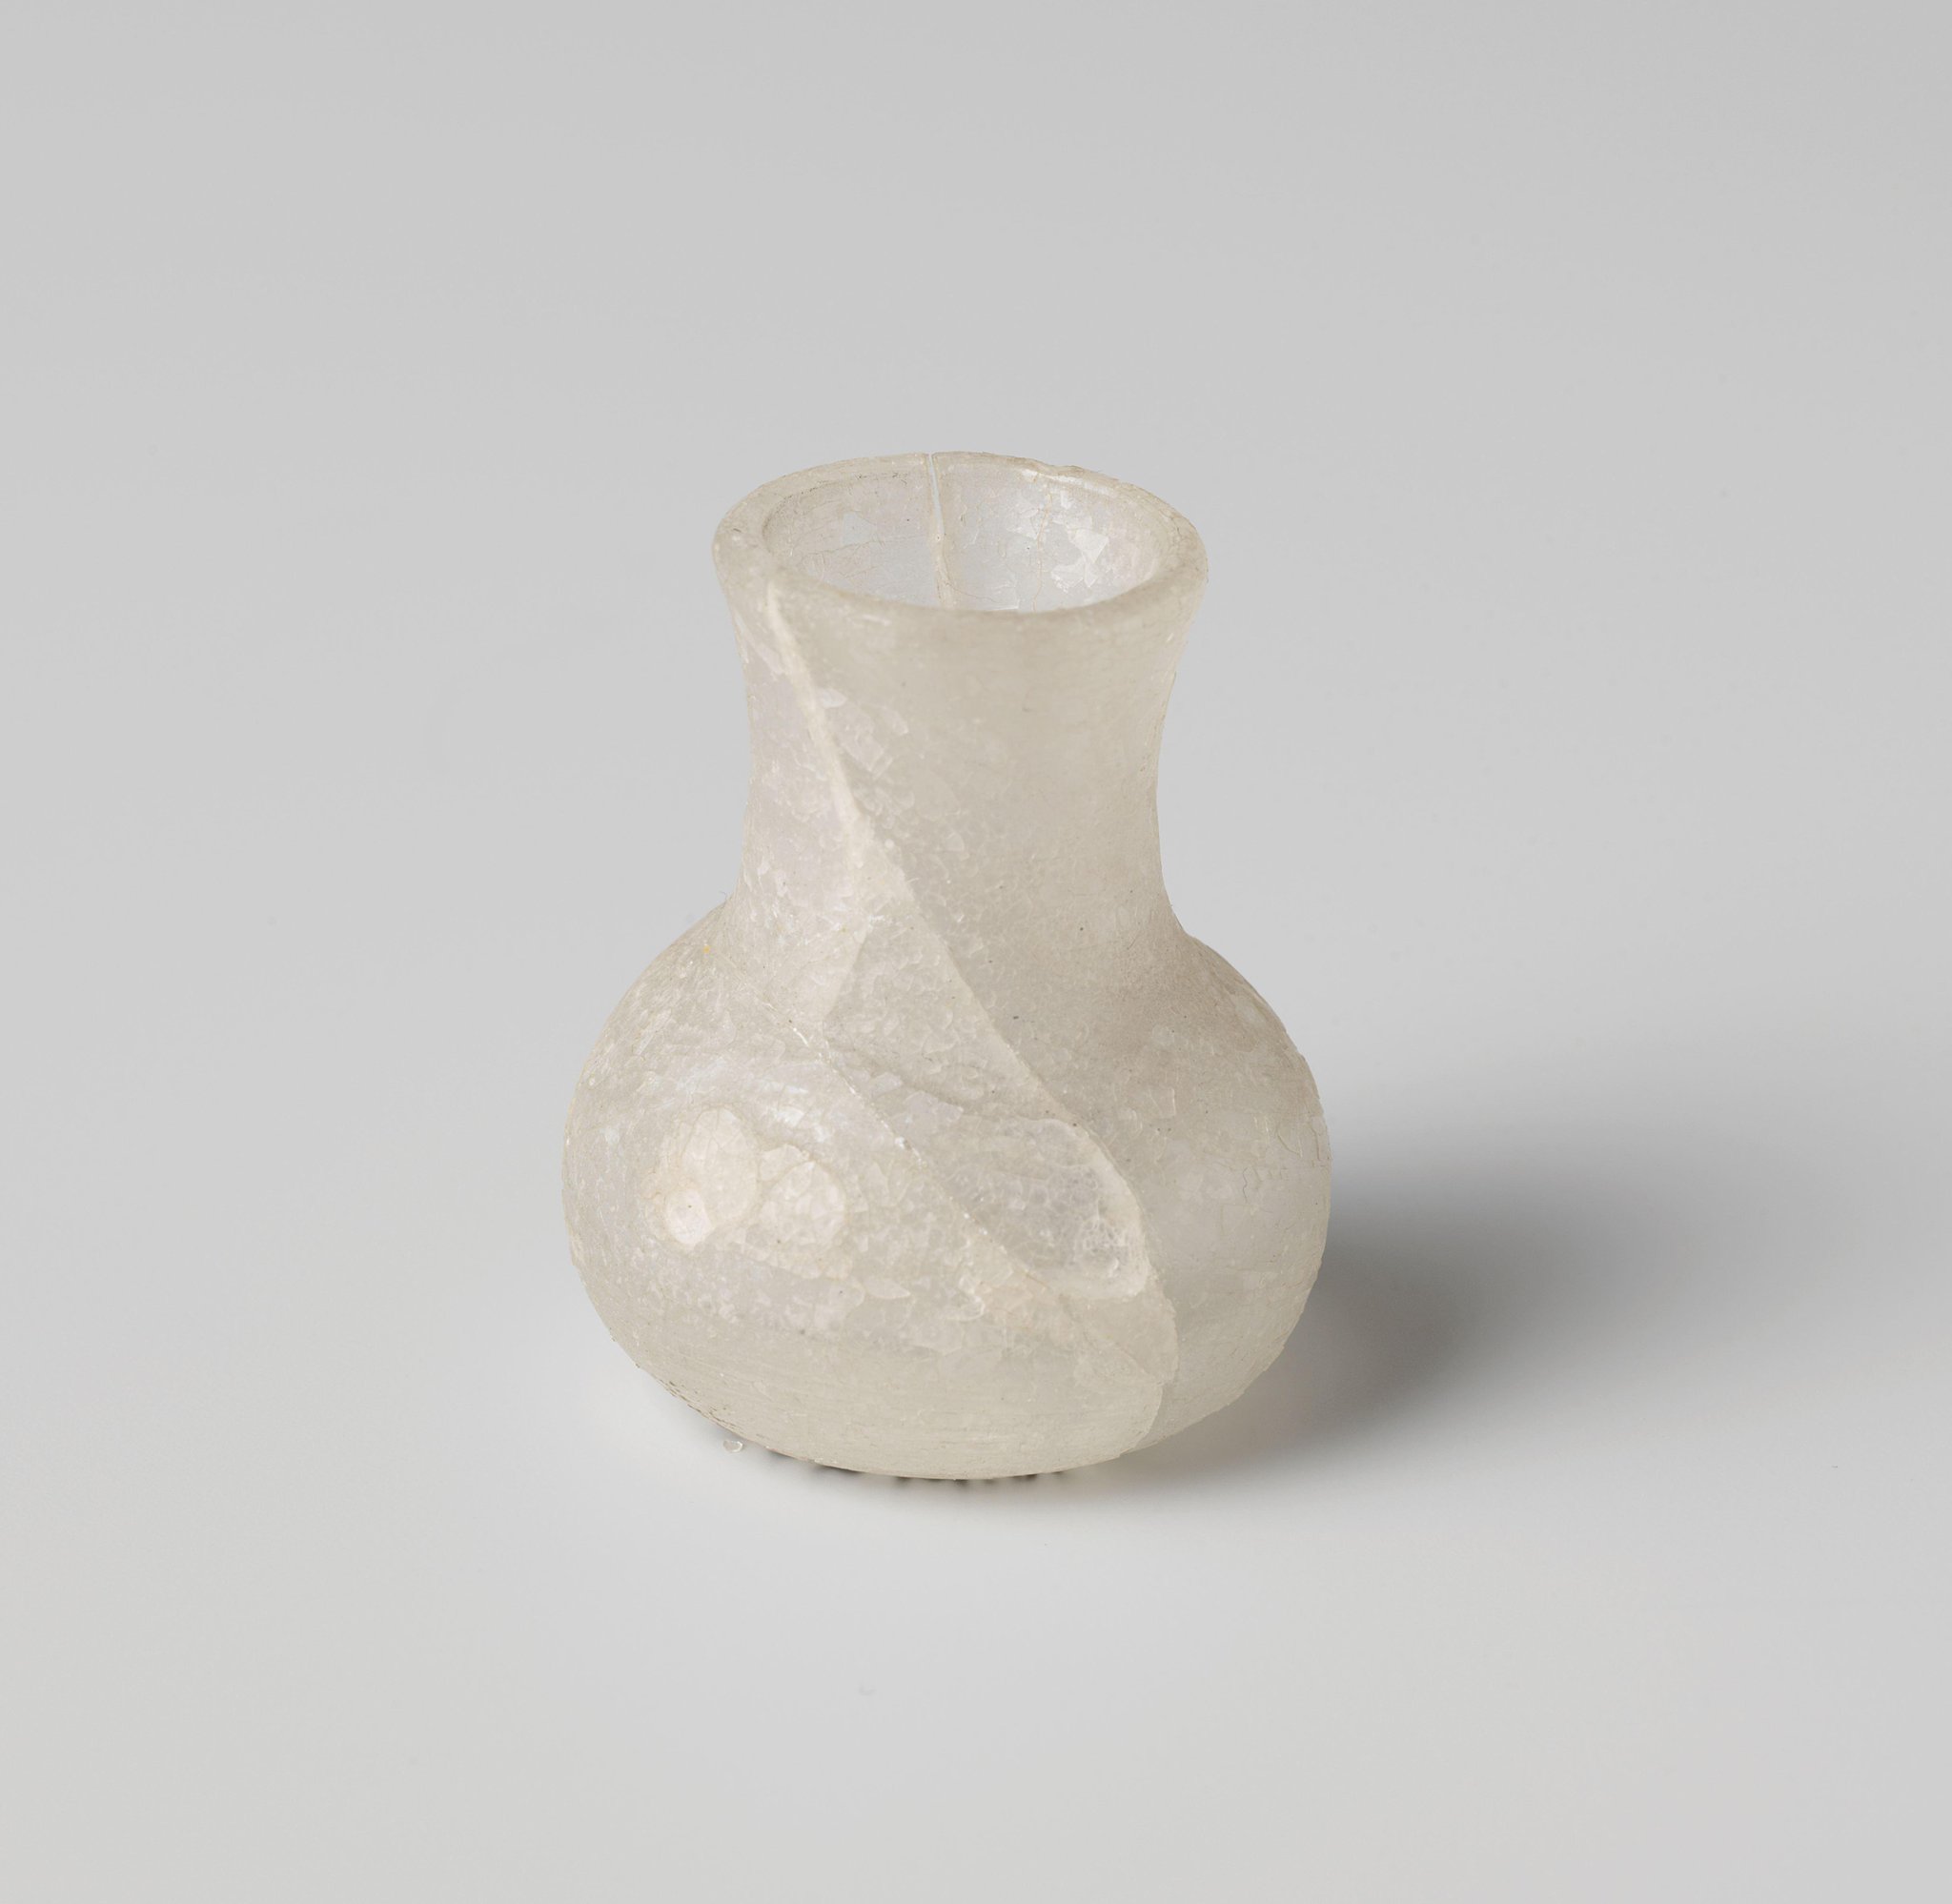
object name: miniature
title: Vaas van kleurloos glas, met bolle buik en iets uitlopende hals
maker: Anonymous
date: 1700-1799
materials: glass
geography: netherlands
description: Vaas oorspronkelijk van helder, kleurloos glas, nu door glasziekte ernstig aangetast. Bolle buik met brede hals boven iets uitlopend, iets holle bodem.